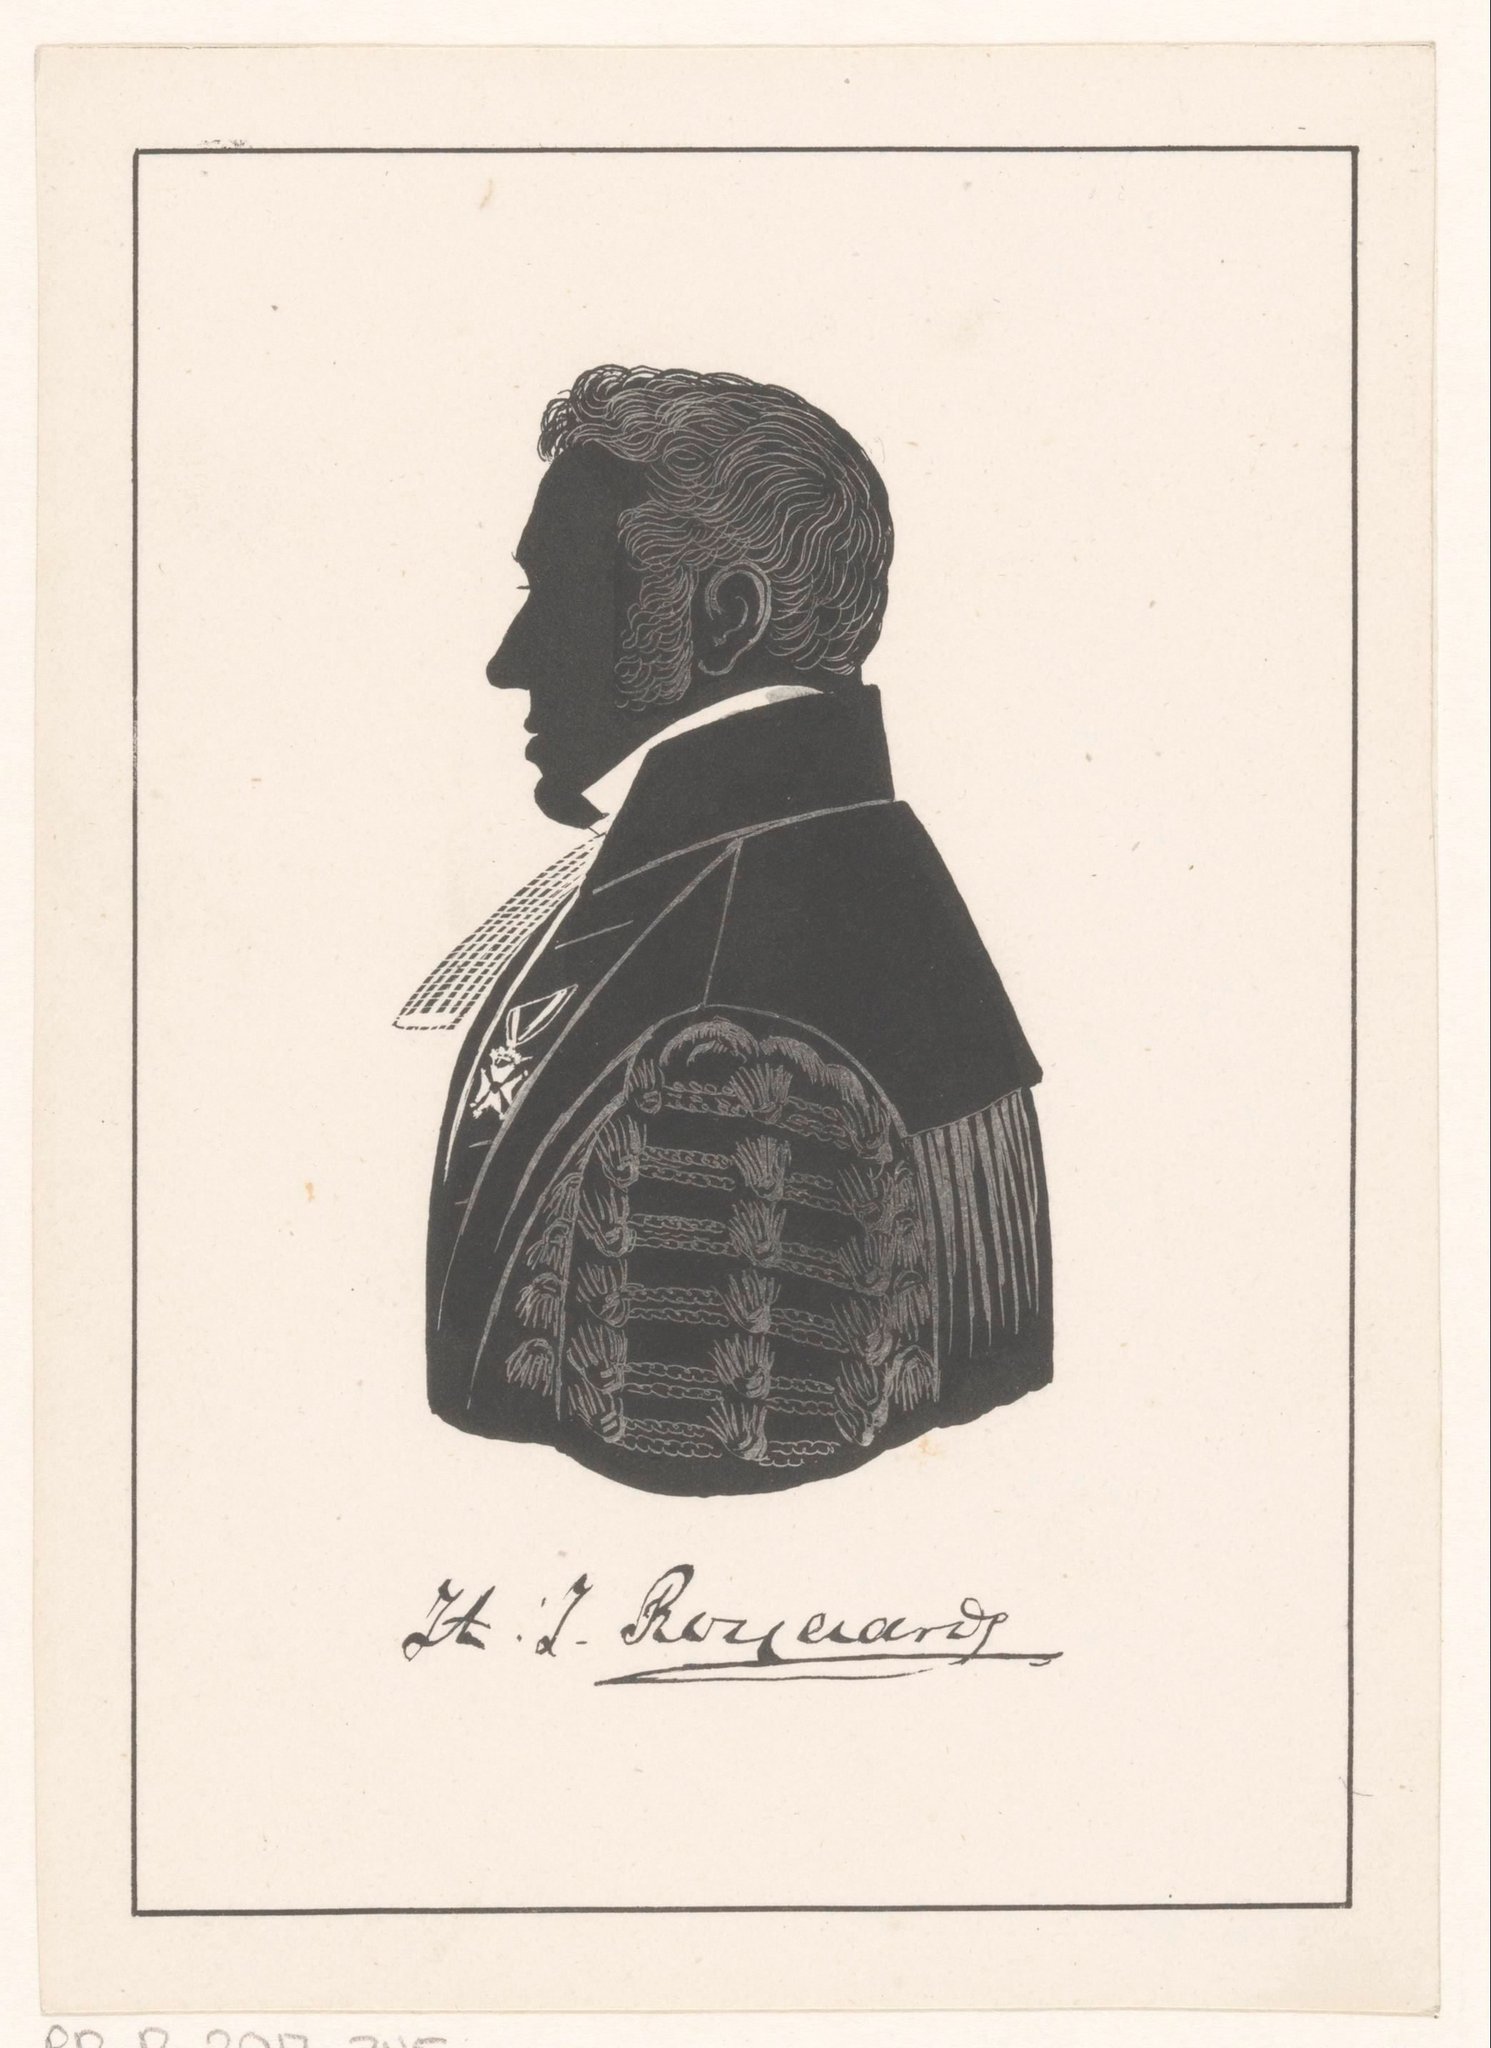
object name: print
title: Silhouetportret van Herman Johan Royaards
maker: pieter barbiers (iv)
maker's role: painter, print maker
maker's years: 1798-1848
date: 1809-1848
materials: paper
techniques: hand coloring, lithograph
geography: netherlands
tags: utrecht, herman johan royaards, historical persons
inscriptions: collector's mark: Lugt 2228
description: Onder het portret de signatuur van de geportretteerde.